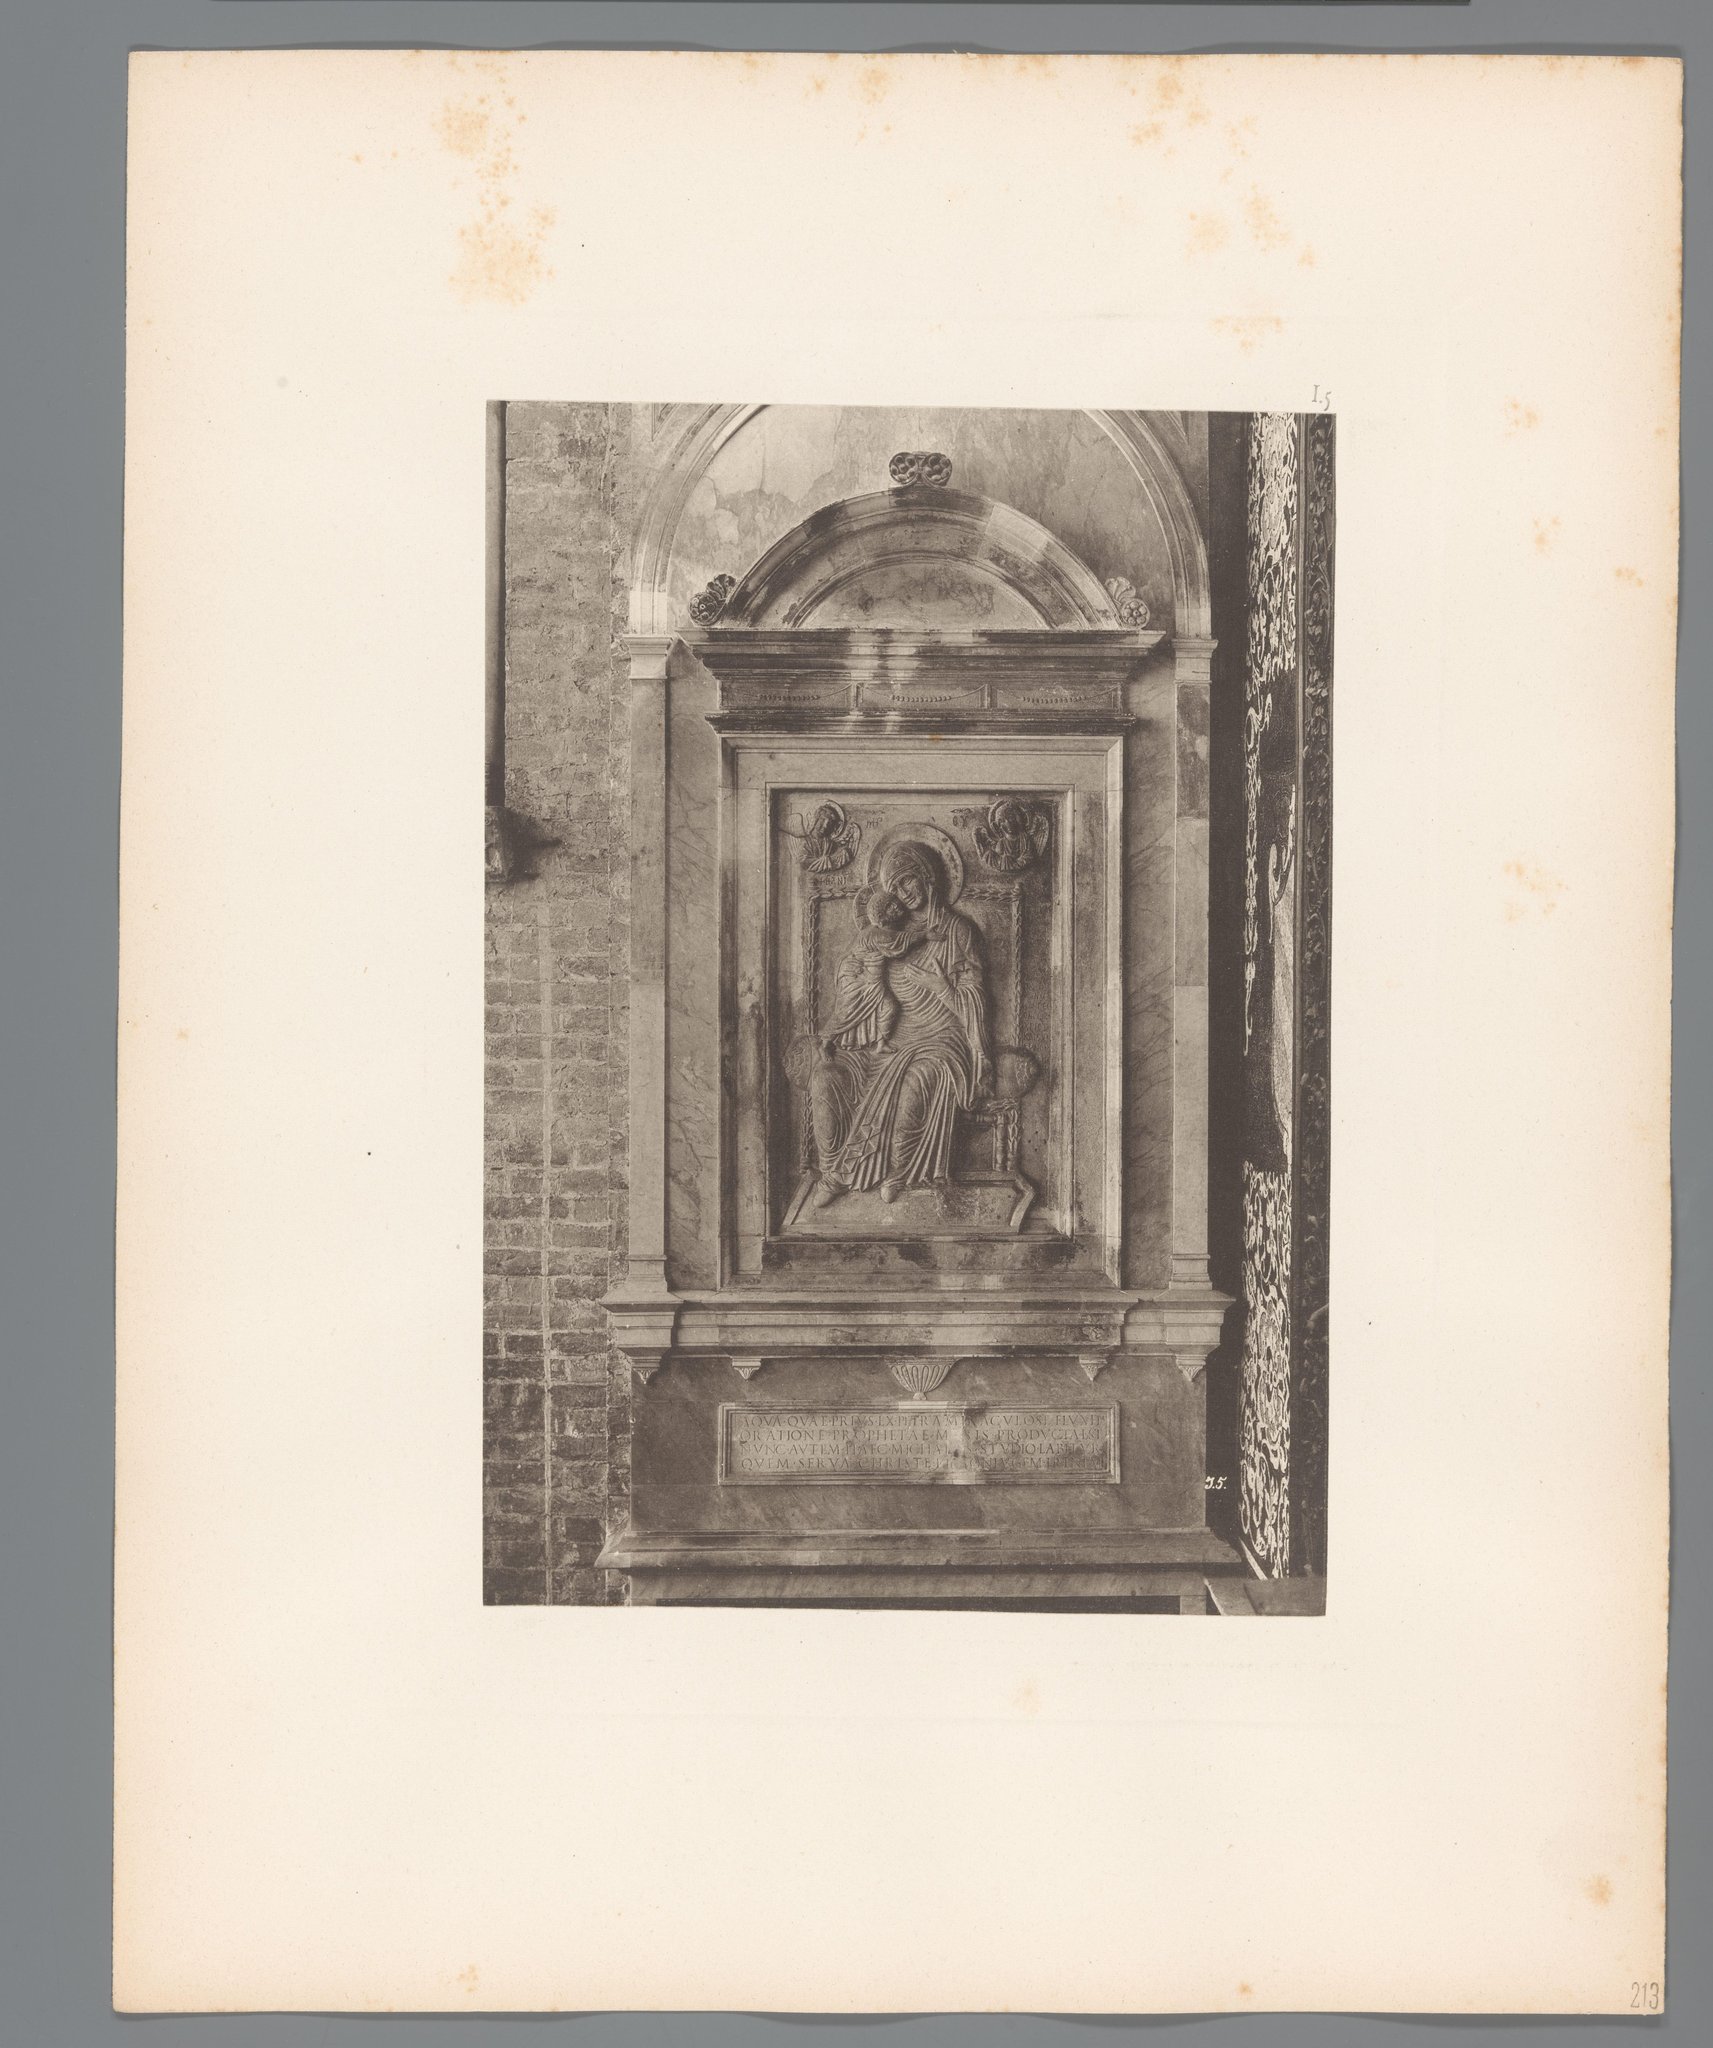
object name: photomechanical print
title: Reliëf van Maria en Christus van de San Marco in Venetië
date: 1880-1885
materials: paper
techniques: photograph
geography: st. mark's basilica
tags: mary sitting or enthroned, the christ-child in front of her, standing in her lap (or in front of her bosom), piece of sculpture, reproduction of a piece of sculpture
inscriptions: number: ‘J.5.’, number: ‘I.5’, number: ‘213’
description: Deze prent maakt deel uit van een omslag met 79 prenten op 53 bladen en 2 tekstbladen.